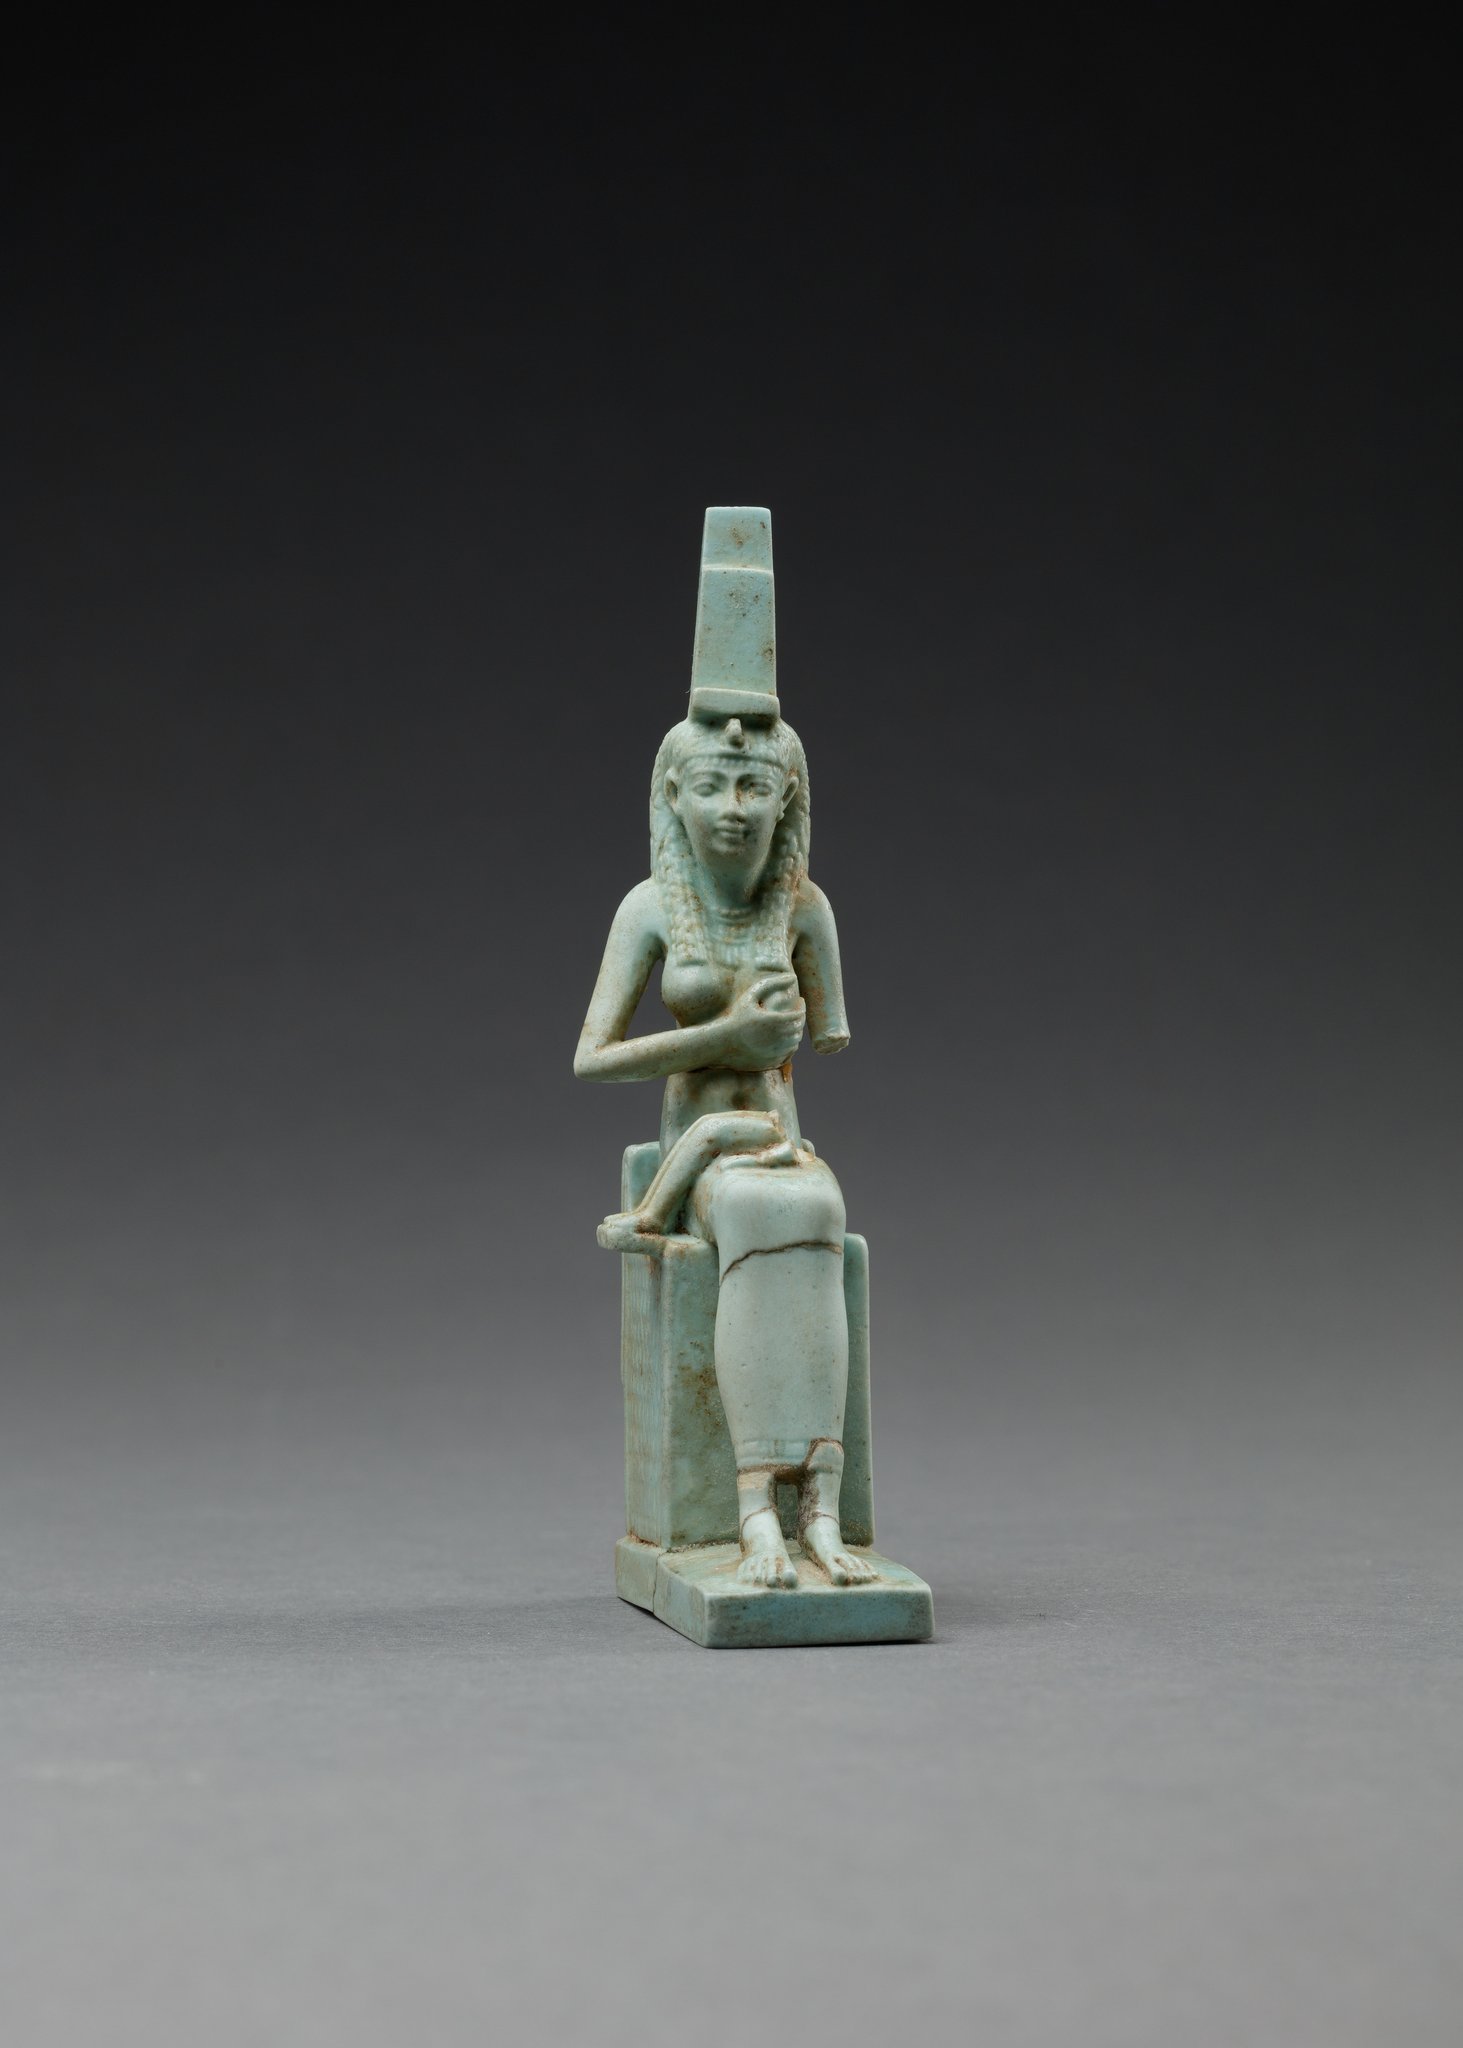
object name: isi nursing horus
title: Isis nursing Horus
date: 664-630 BCE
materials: faience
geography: egypt